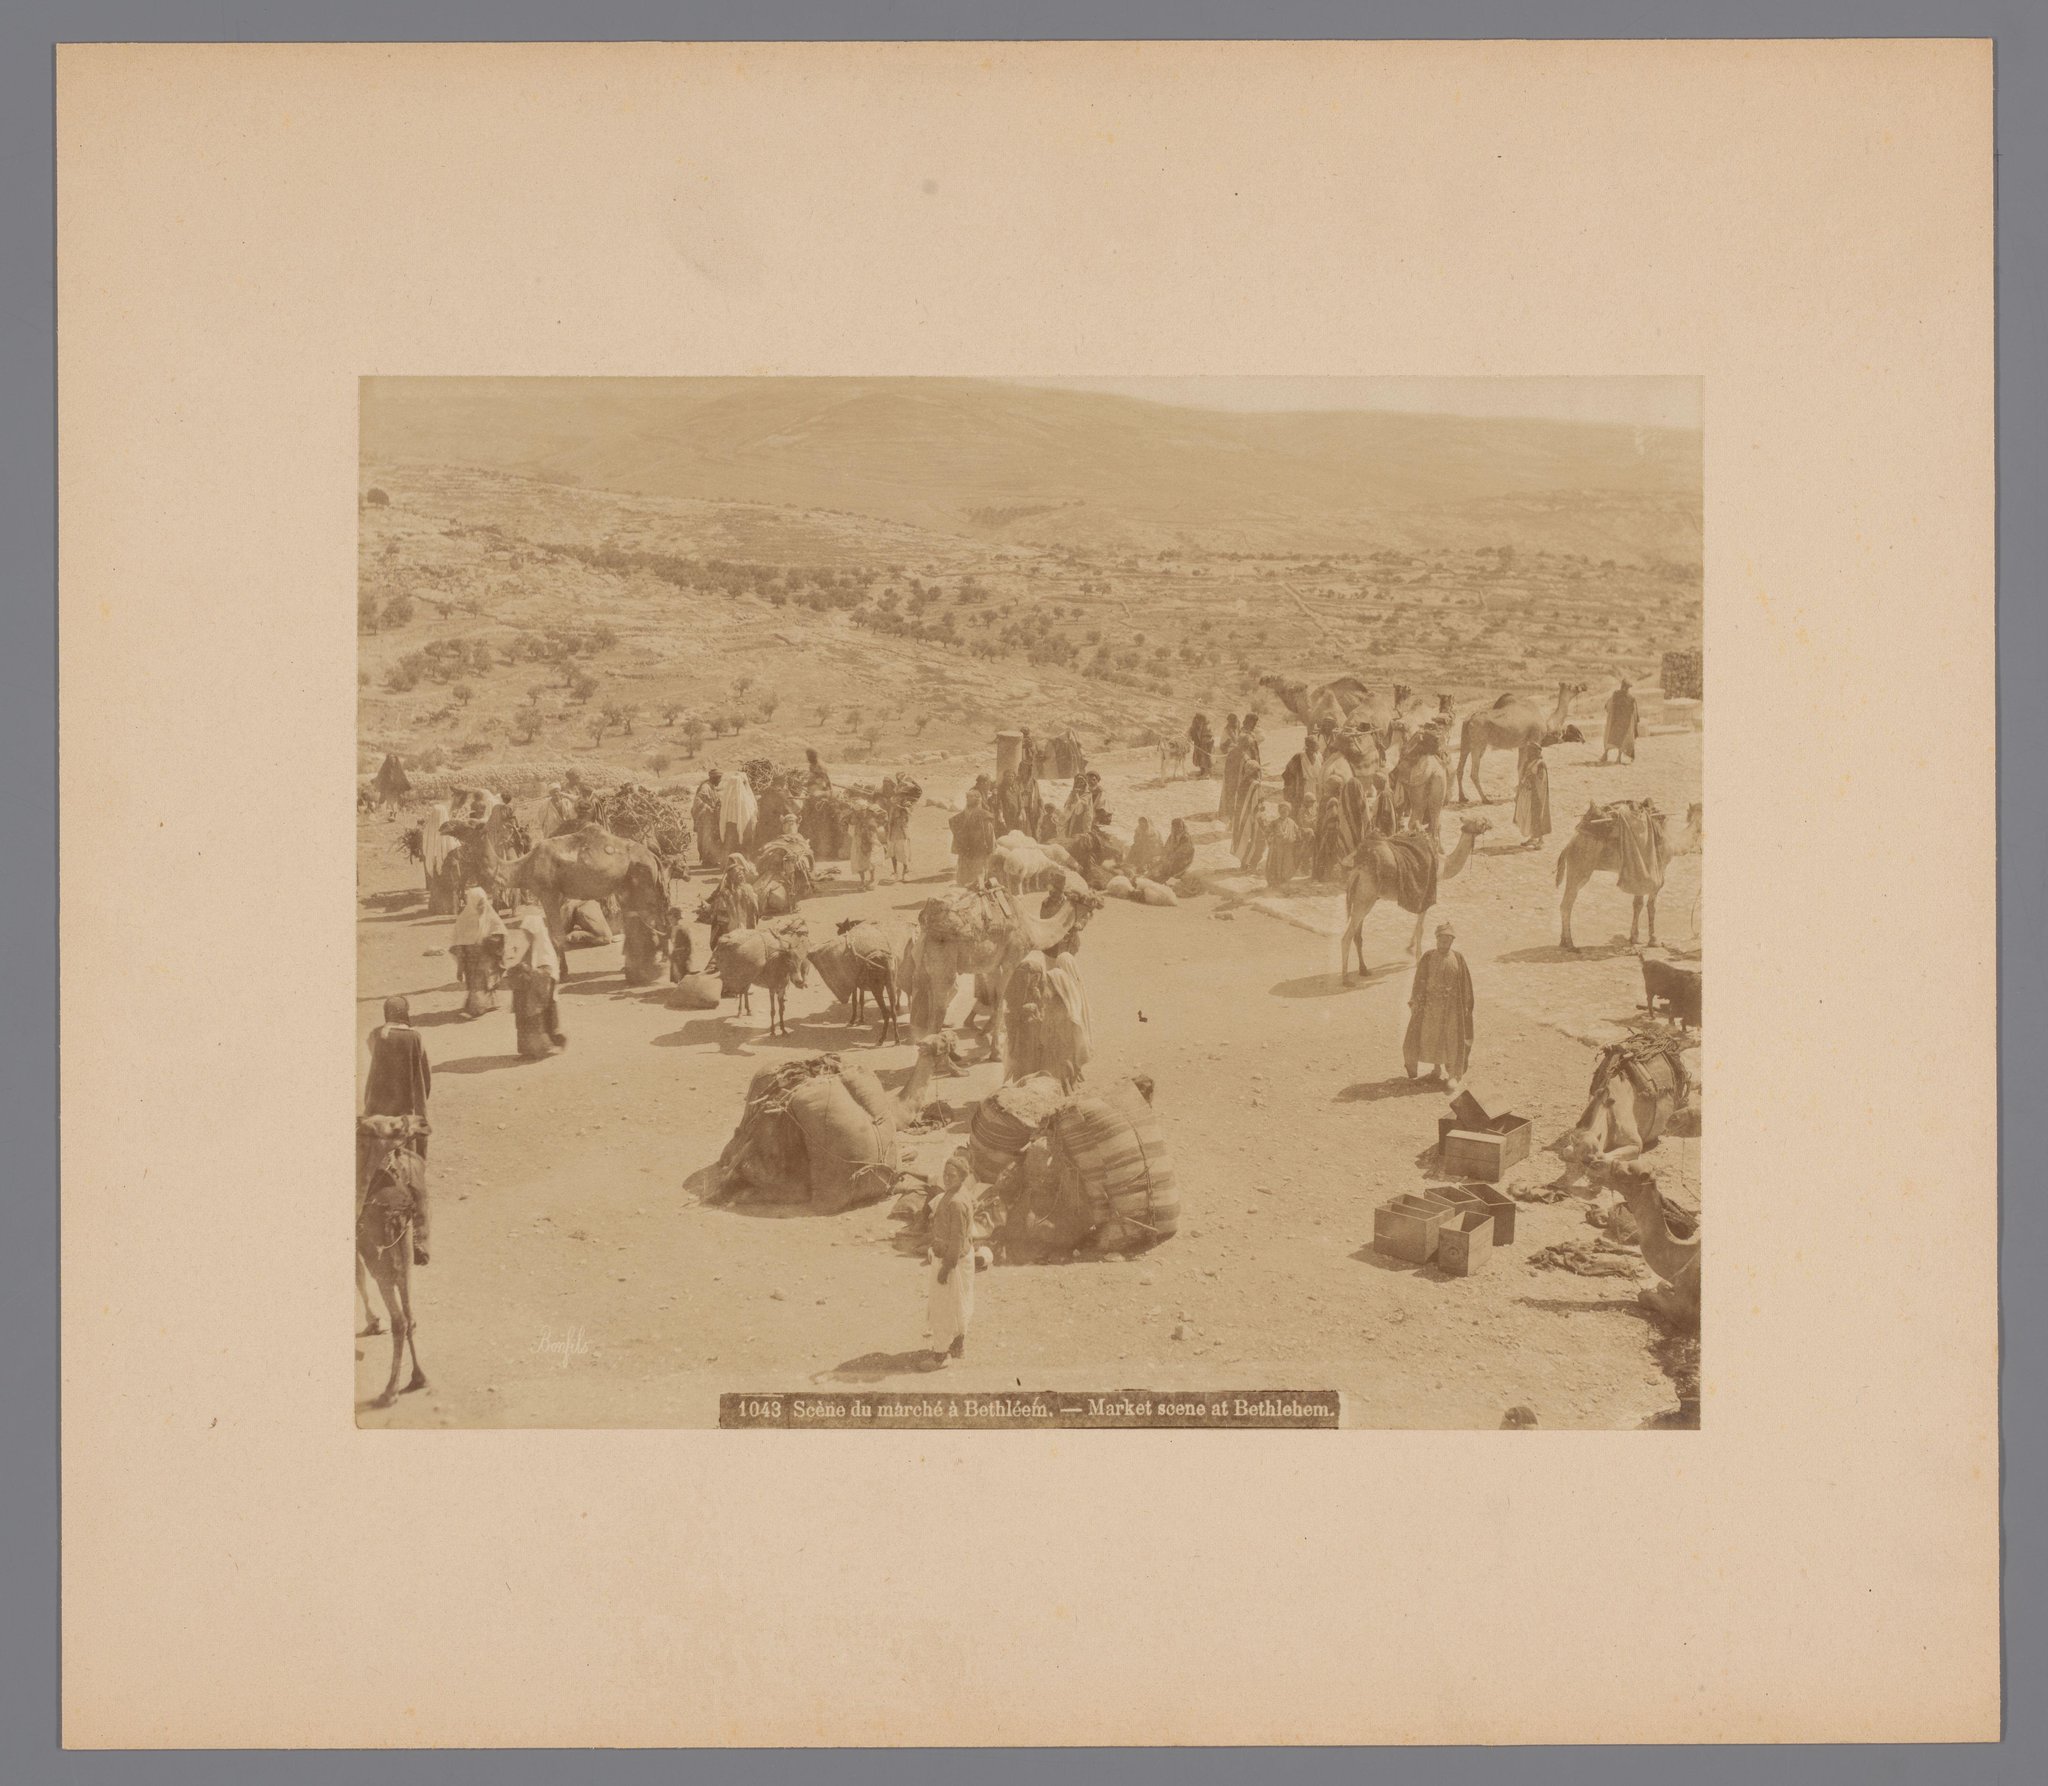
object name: photograph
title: Marktscène in Betlehem, Jeruzalem, Palestina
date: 1850-1900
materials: paper, photographic support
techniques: albumen print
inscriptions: inscription: ‘1043 Scène du marché à Bethléem. - Market scene at Bethlehem’, inscription: ‘Bonfils.’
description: Marktscène in Betlehem, Jeruzalem, Palestina.